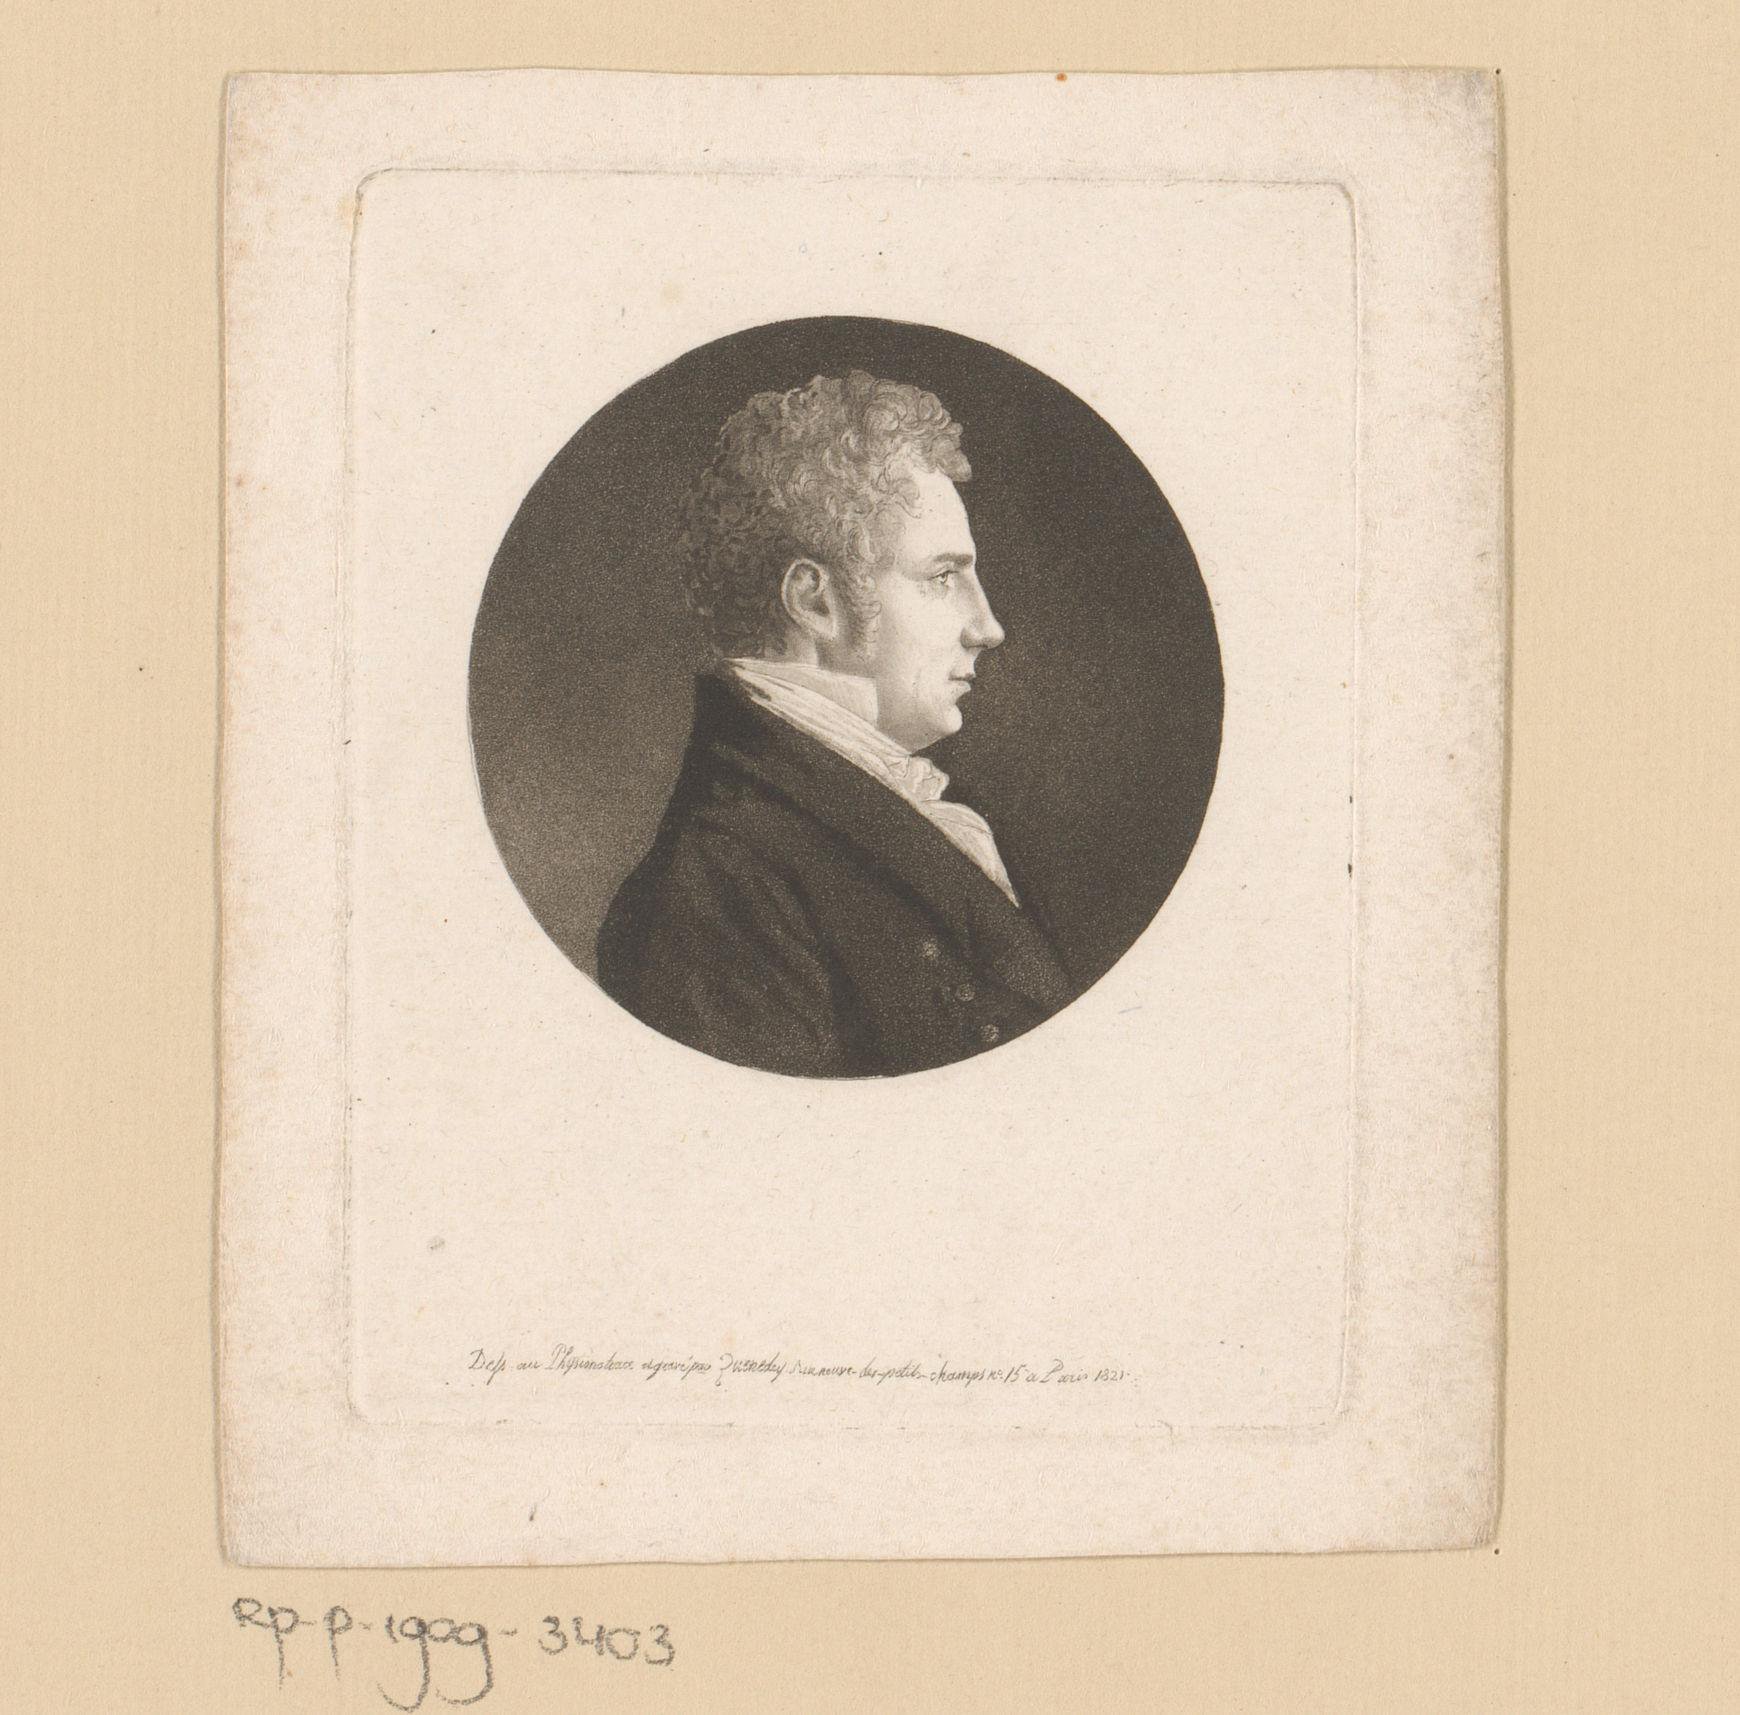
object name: print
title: Portret van een onbekende man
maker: edme quenedey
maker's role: print maker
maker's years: 1756-1830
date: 1821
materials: paper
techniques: aquatint, etching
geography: paris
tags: silhouette-apparatus, 'physionotrace', anonymous historical person portrayed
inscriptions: collector's mark: Lugt 2228